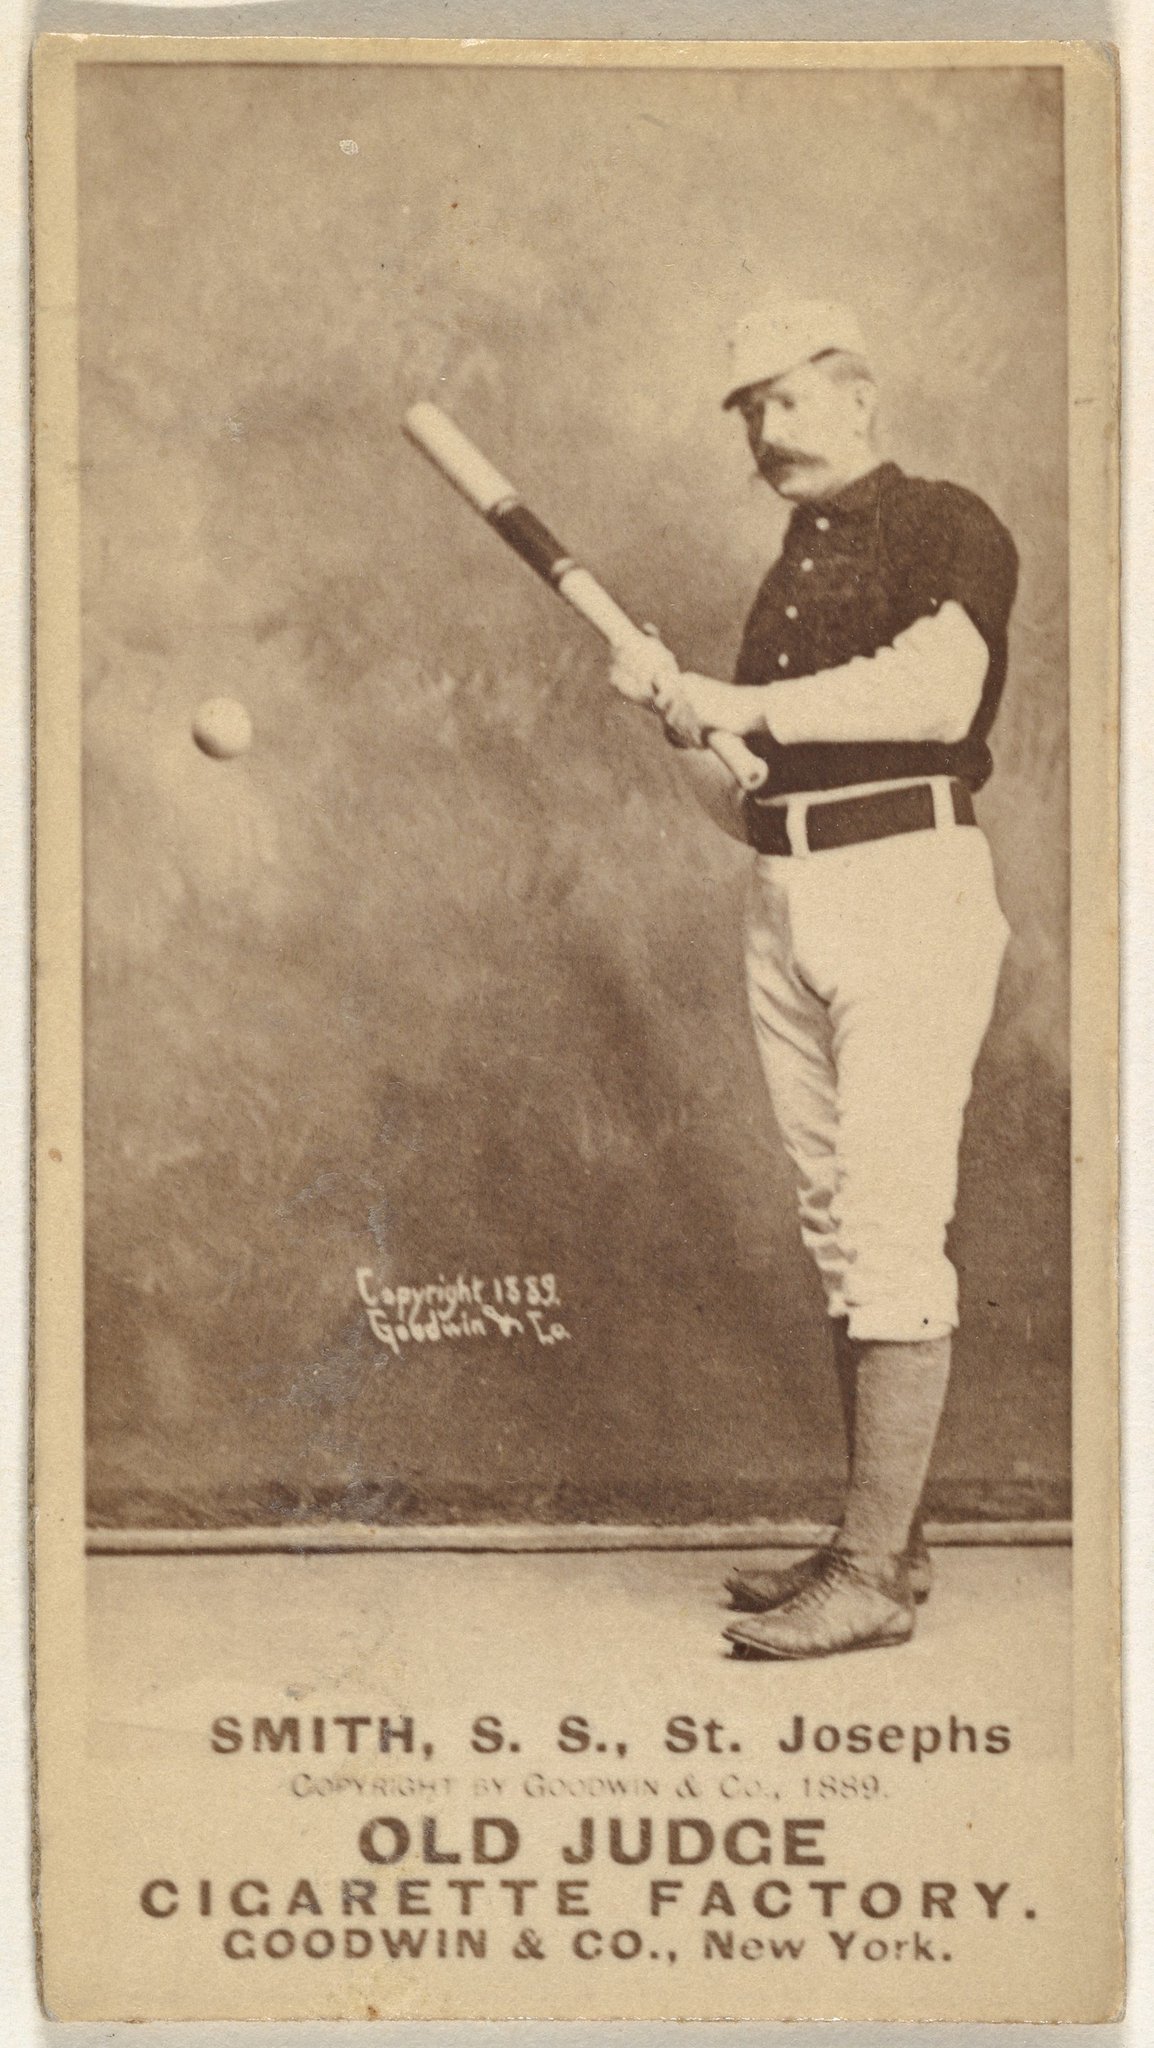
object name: baseball card, photograph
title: H. Smith, Shortstop, St. Joseph Clay Eaters, from the Old Judge series (N172) for Old Judge Cigarettes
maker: goodwin & company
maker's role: publisher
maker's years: 1850-1950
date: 1889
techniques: albumen silver print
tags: men,portraits,baseball,athletes